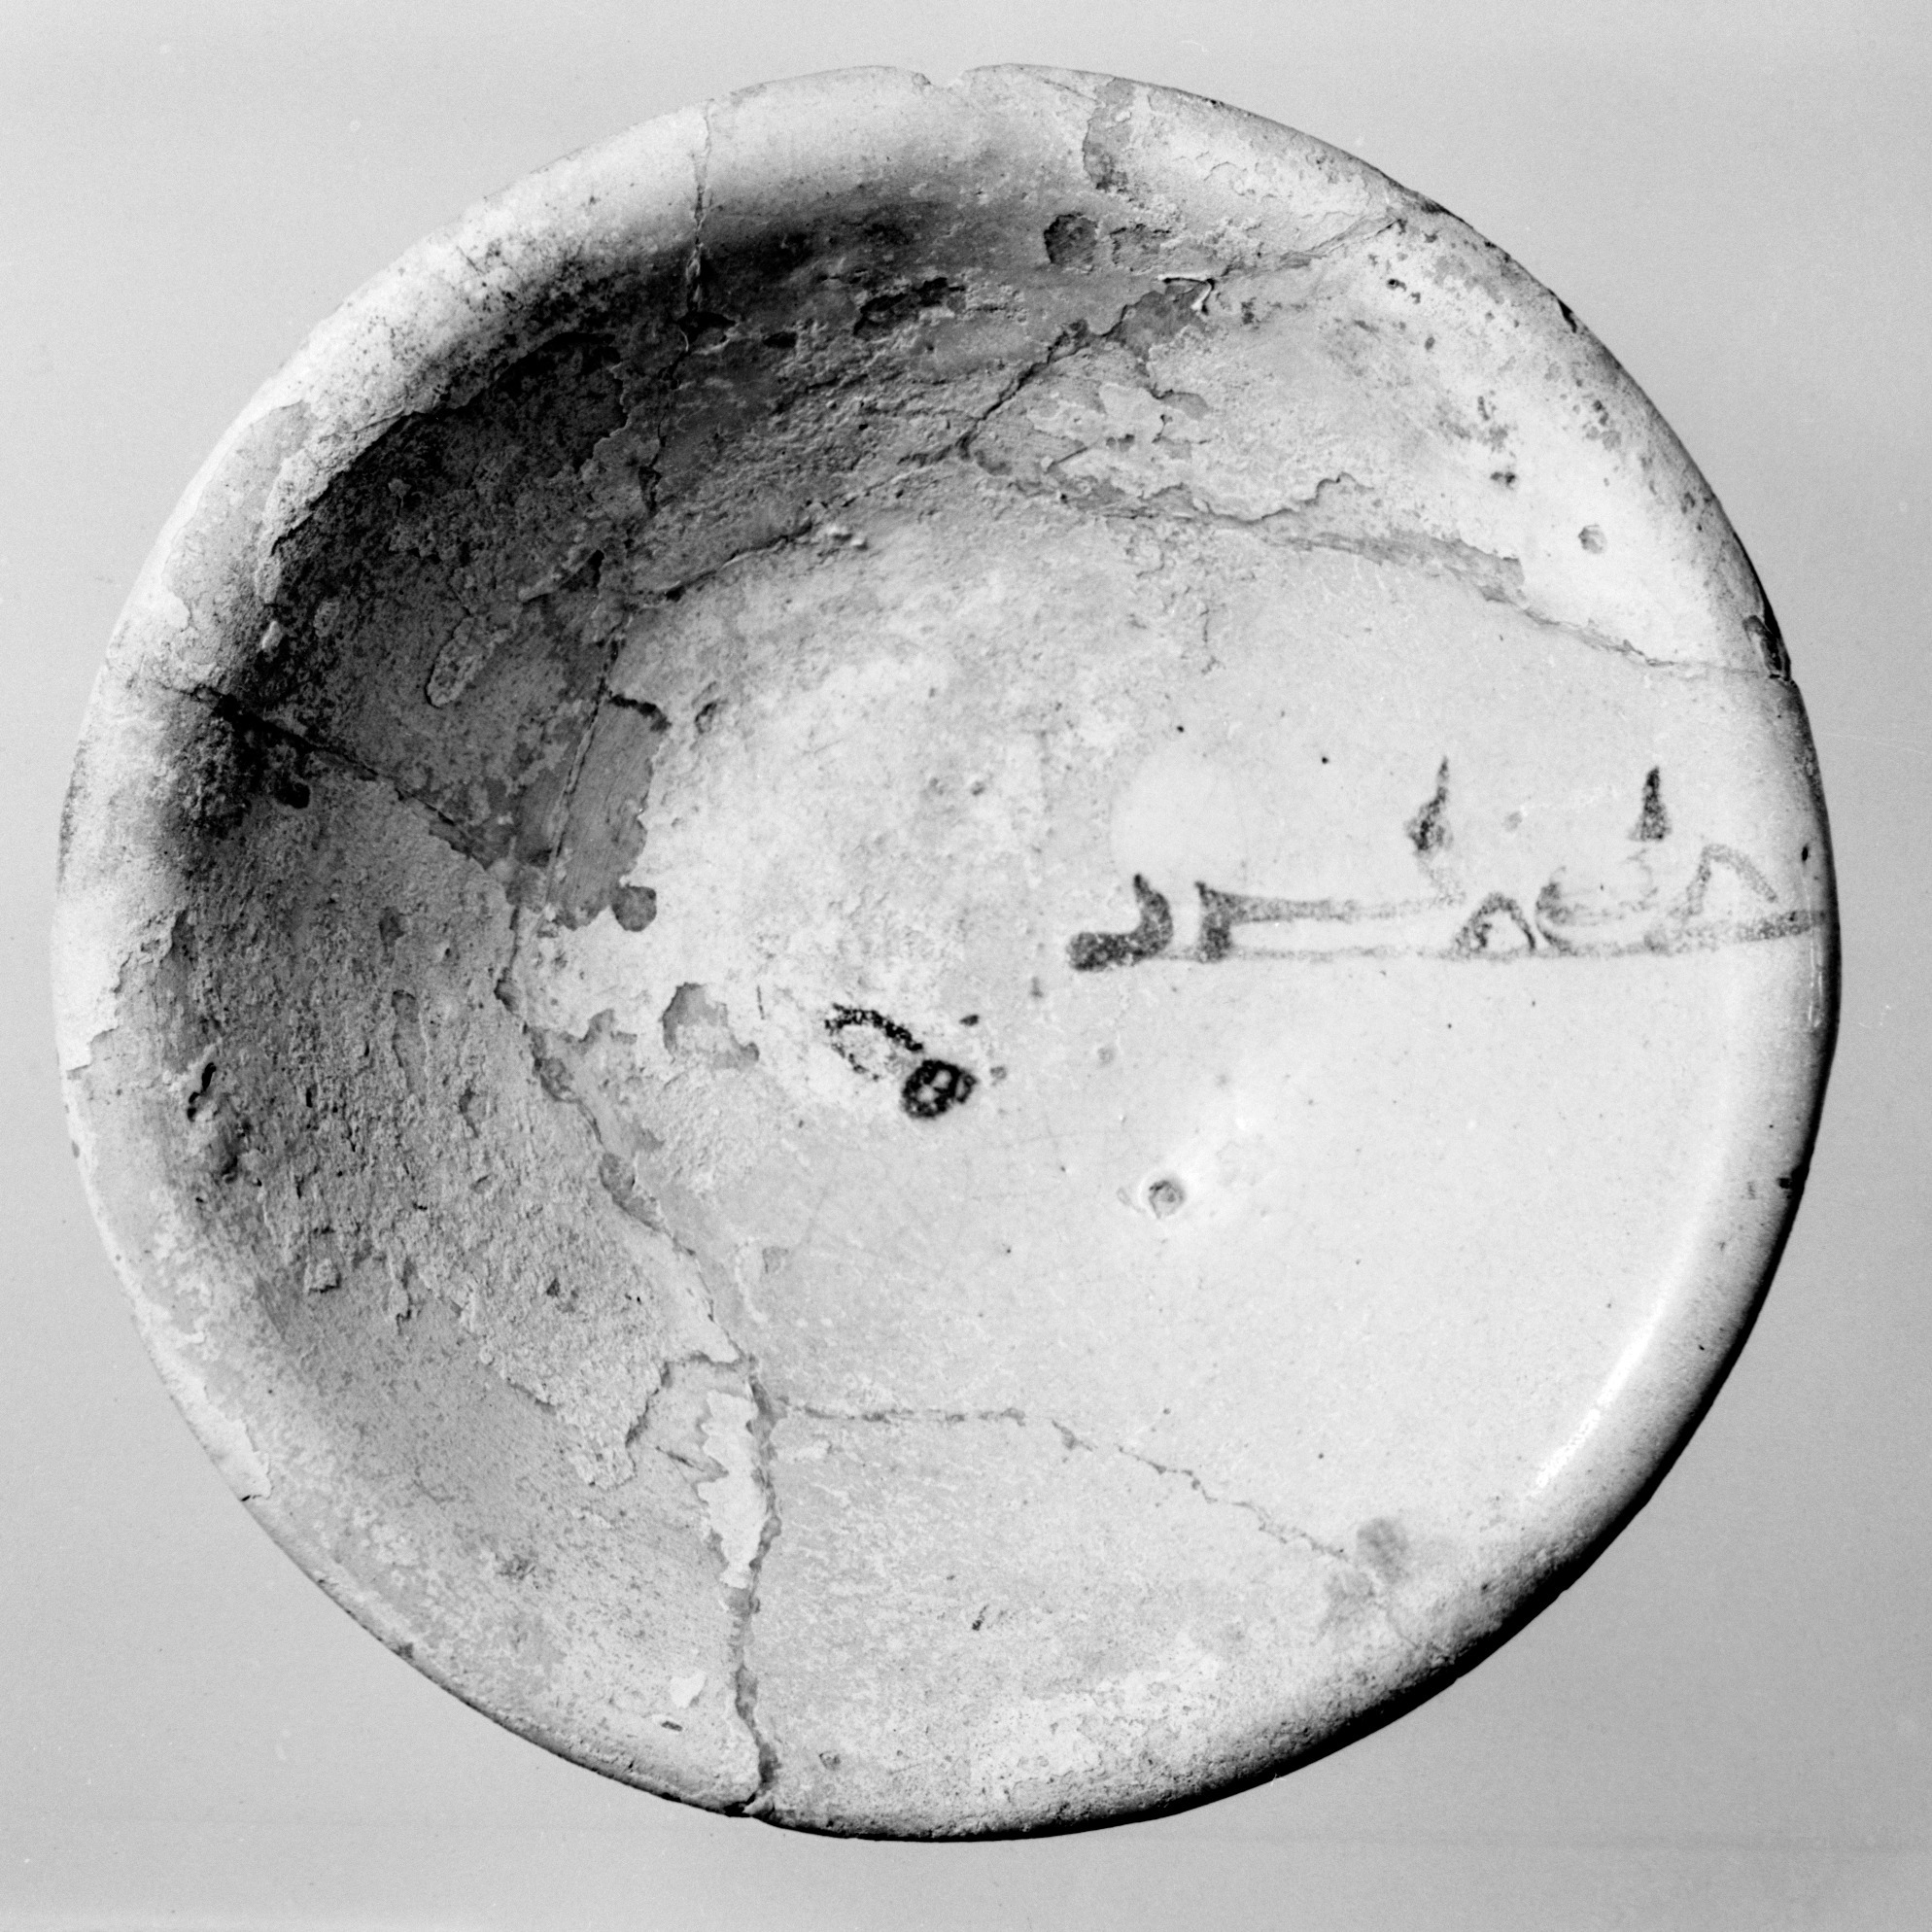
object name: bowl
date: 801-900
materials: earthenware, glaze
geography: iran